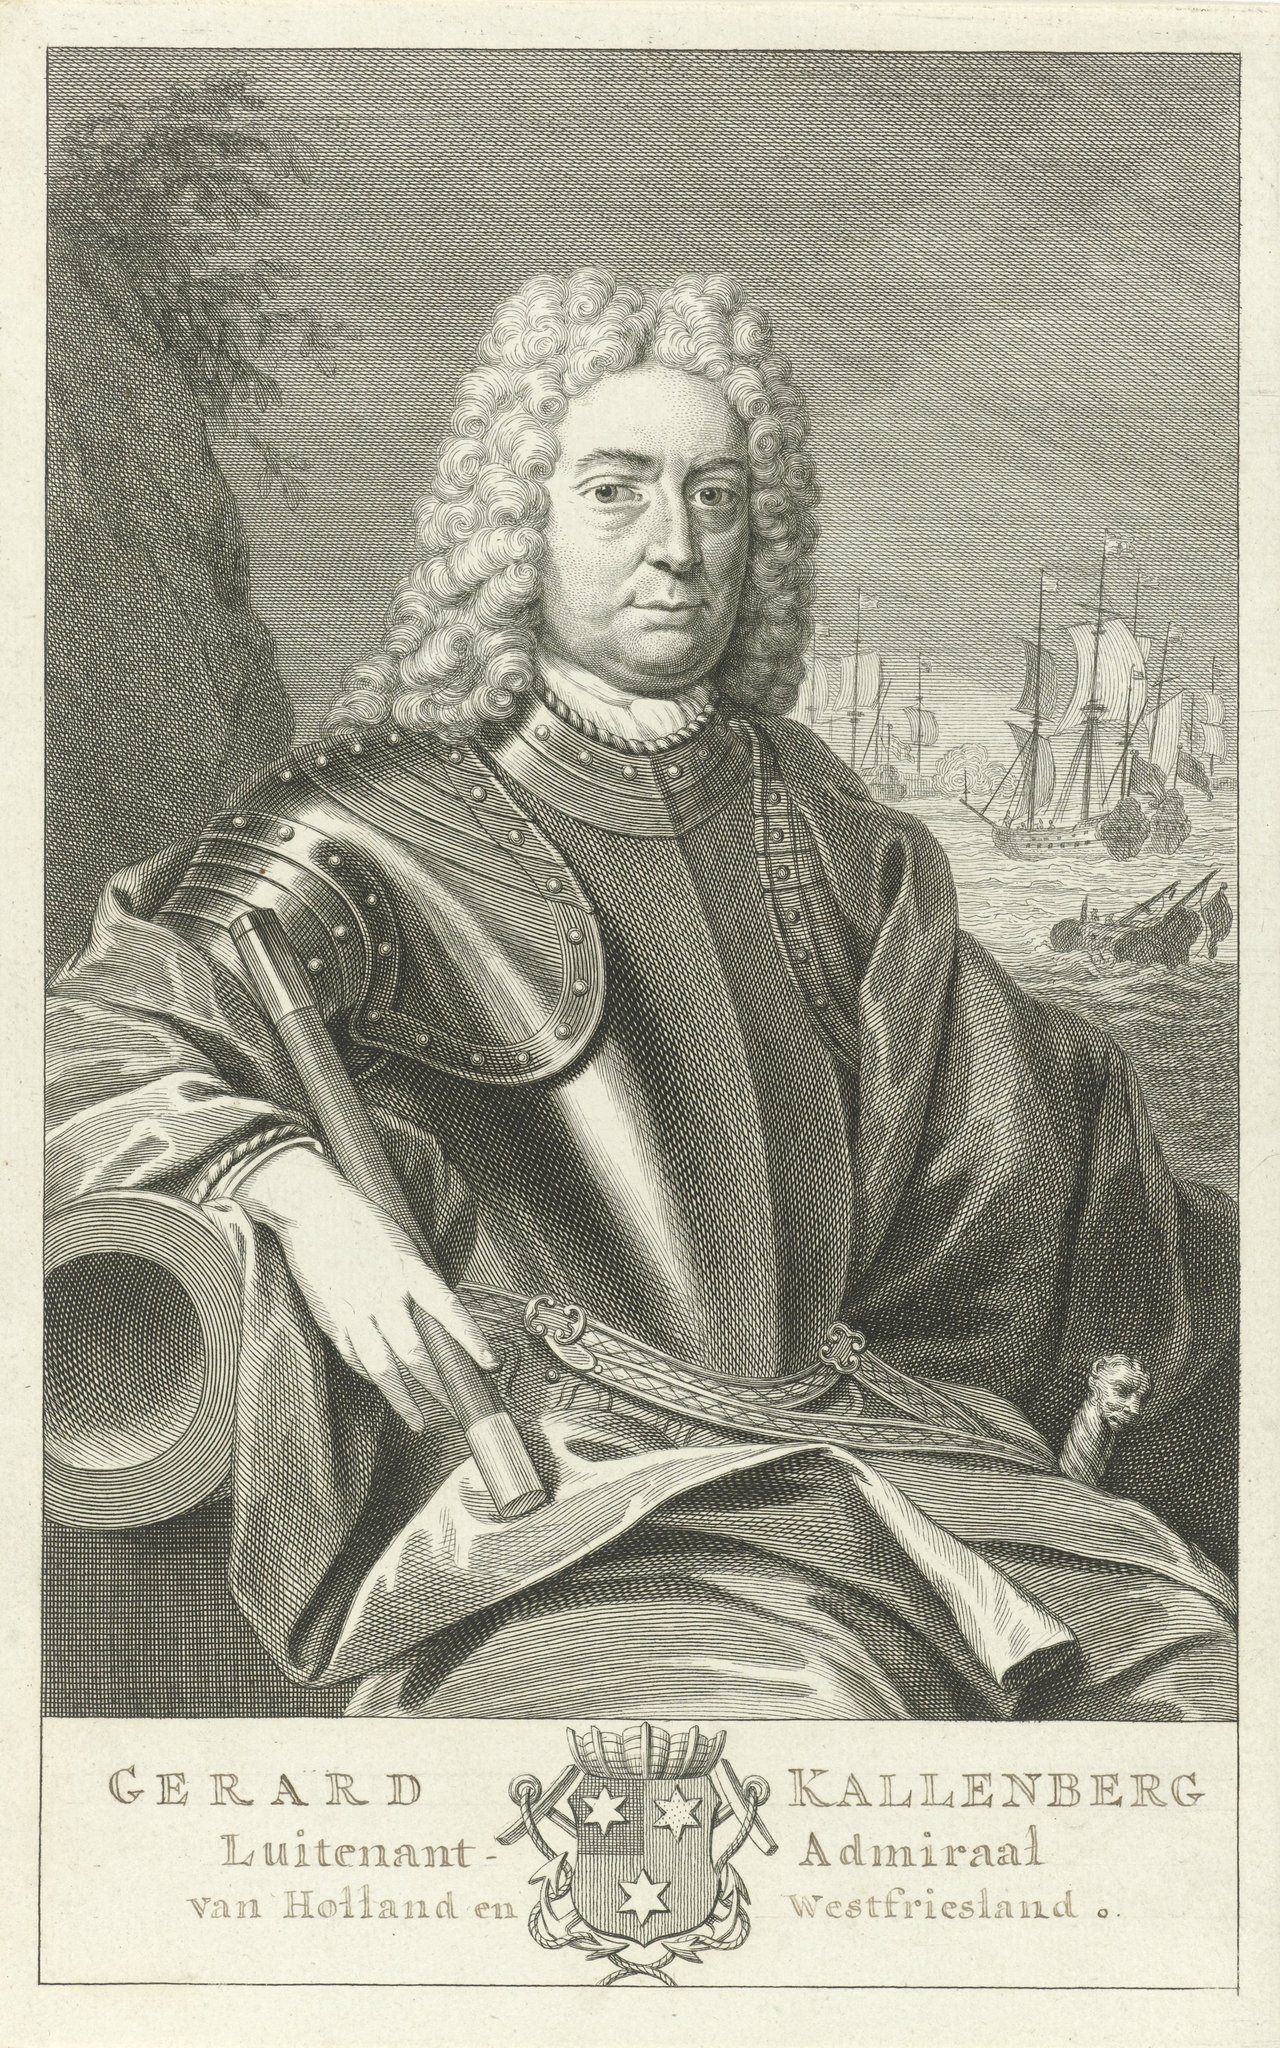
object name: print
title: Portret van Gerard Callenburgh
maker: pieter tanjé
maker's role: draughtsman, print maker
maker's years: 1706-1761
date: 1756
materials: paper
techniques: engraving, etching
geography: amsterdam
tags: flushing, gerard callenburgh, sailing-ship, sailing-boat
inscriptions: collector's mark: Lugt 2228, inscription: ‘Gerard Kallenberg Luitenant-Admiraal van Holland en Westfriesland.’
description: Portret van Gerard Callenburgh, luitenant-admiraal van Holland en West-Friesland, met de bevelhebberstaf in zijn hand. Op de achtergrond schepen op zee. Midden onder in de marge zijn wapenschild.